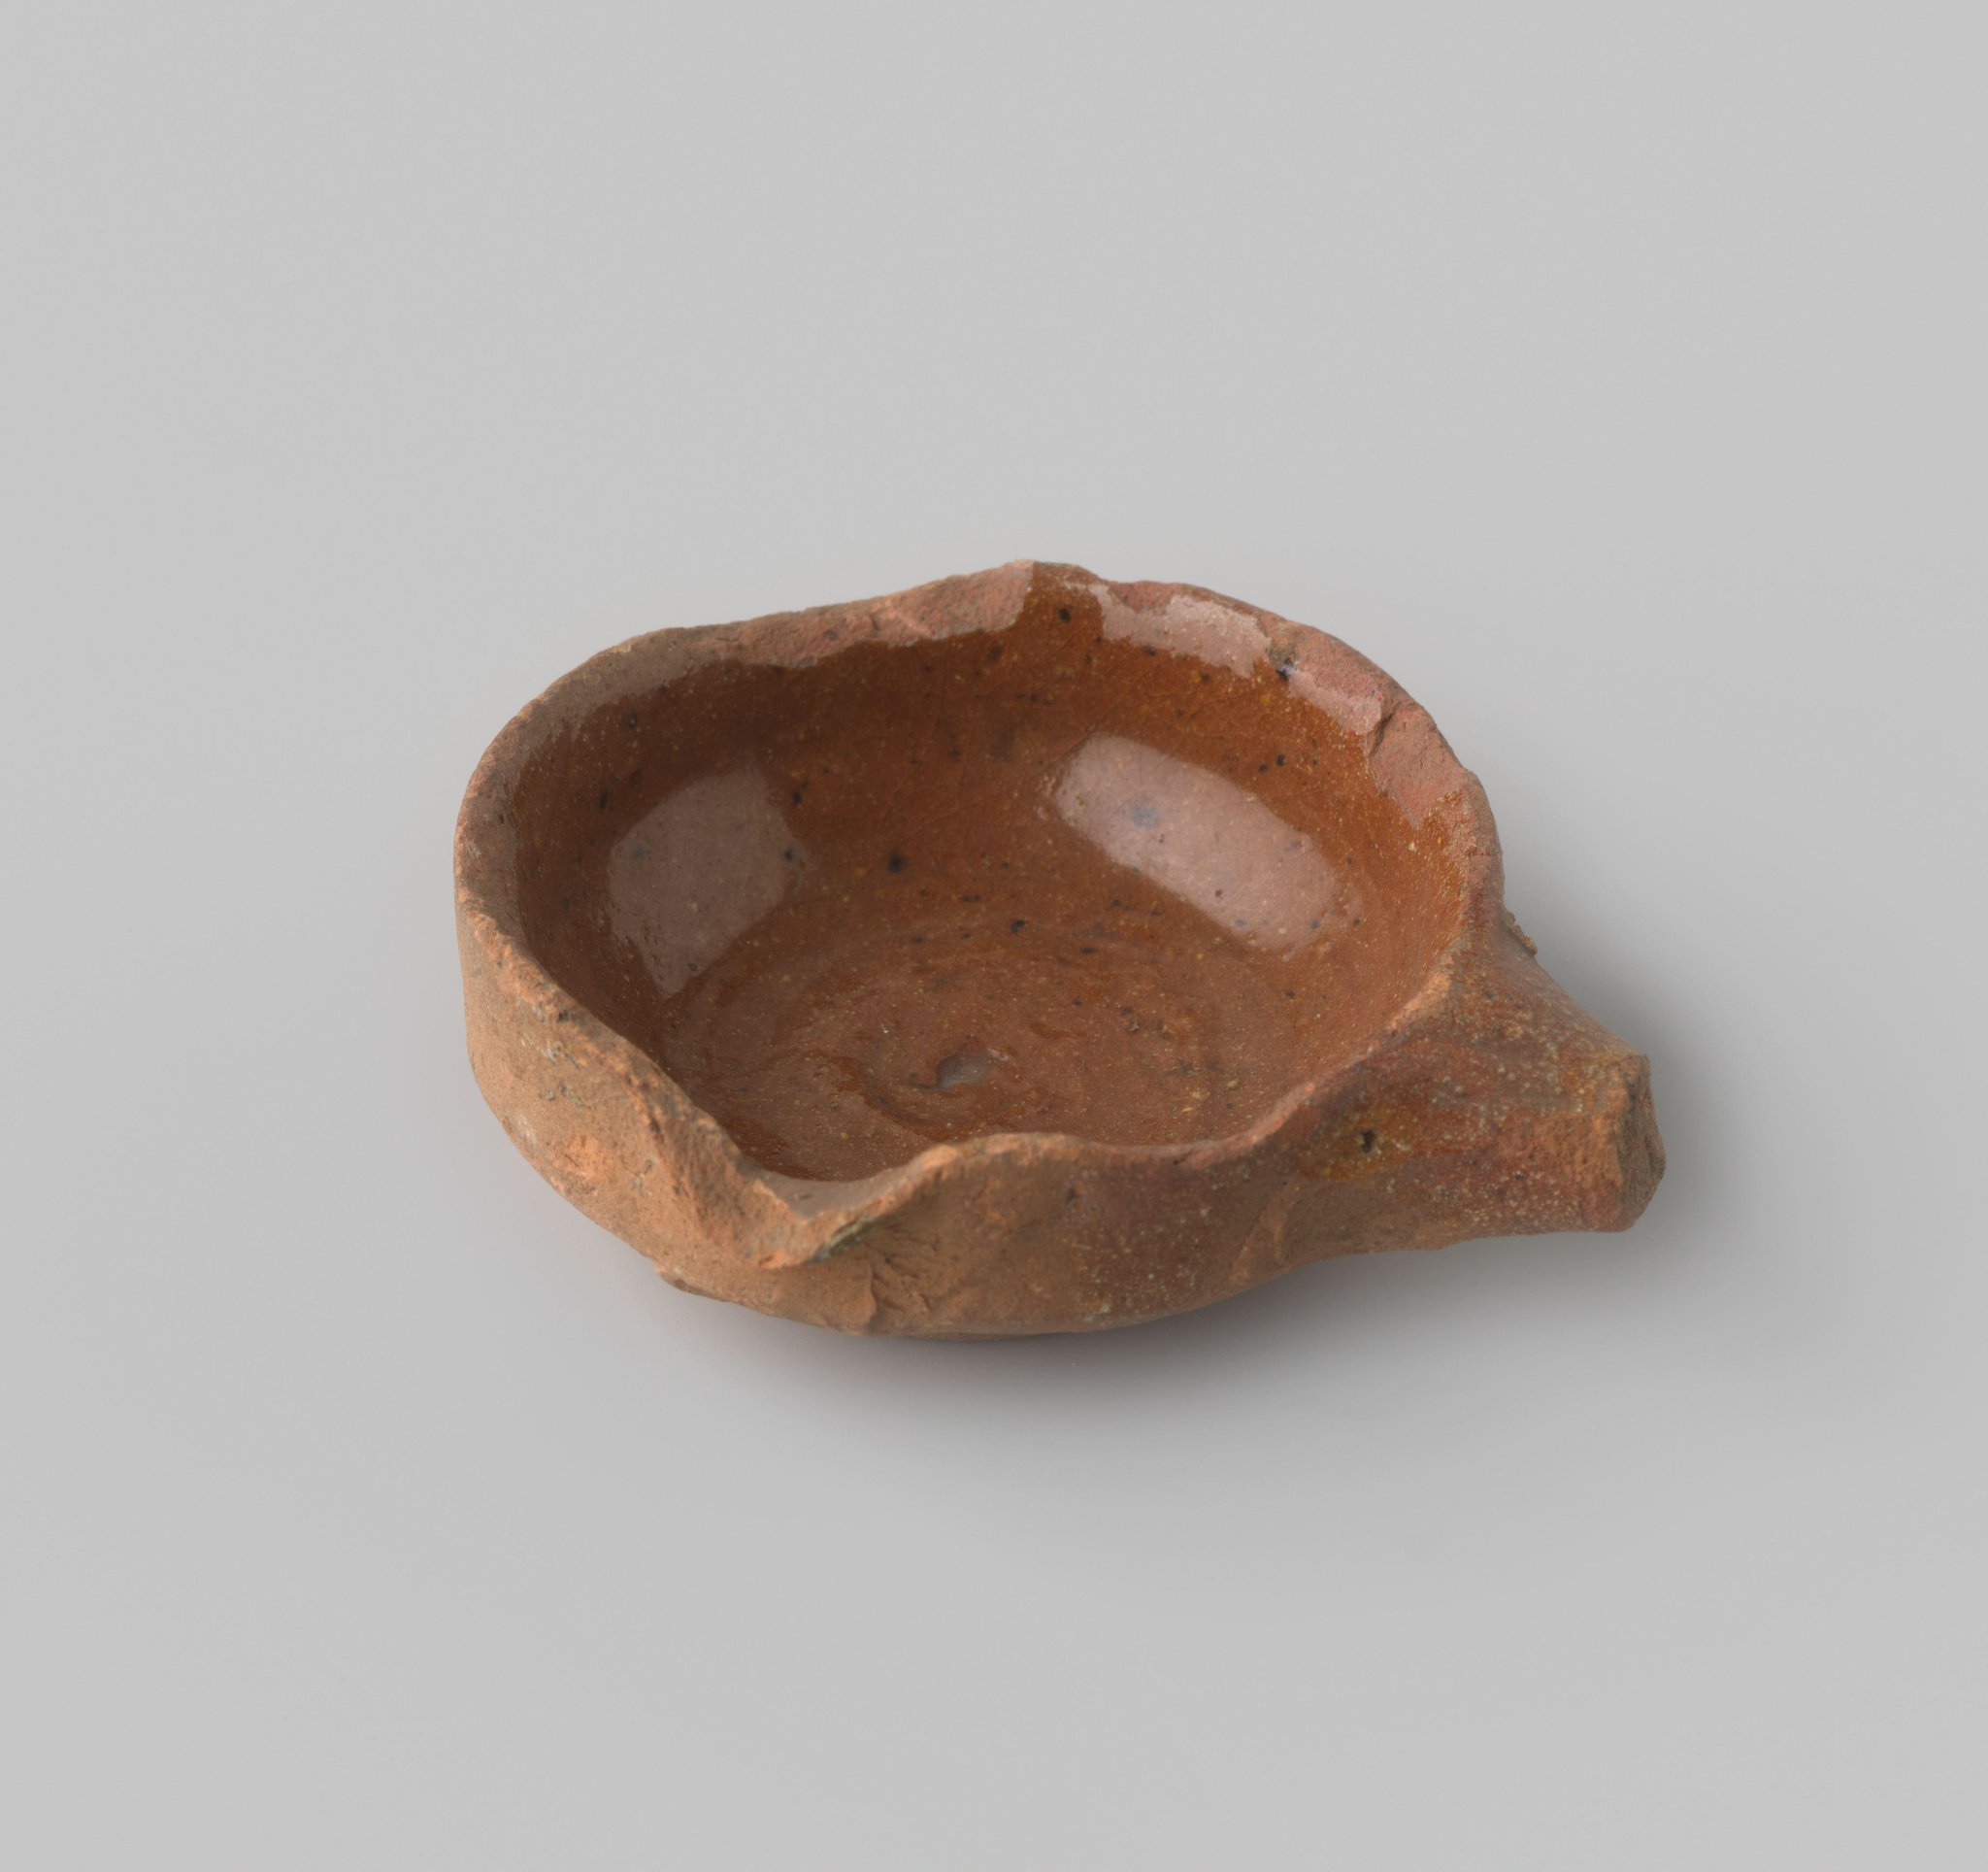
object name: fragment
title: Ronde schaal met handvat en schenktuit, van roodbakkend aardewerk, beschadigd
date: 1500-1899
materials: earthenware, glaze